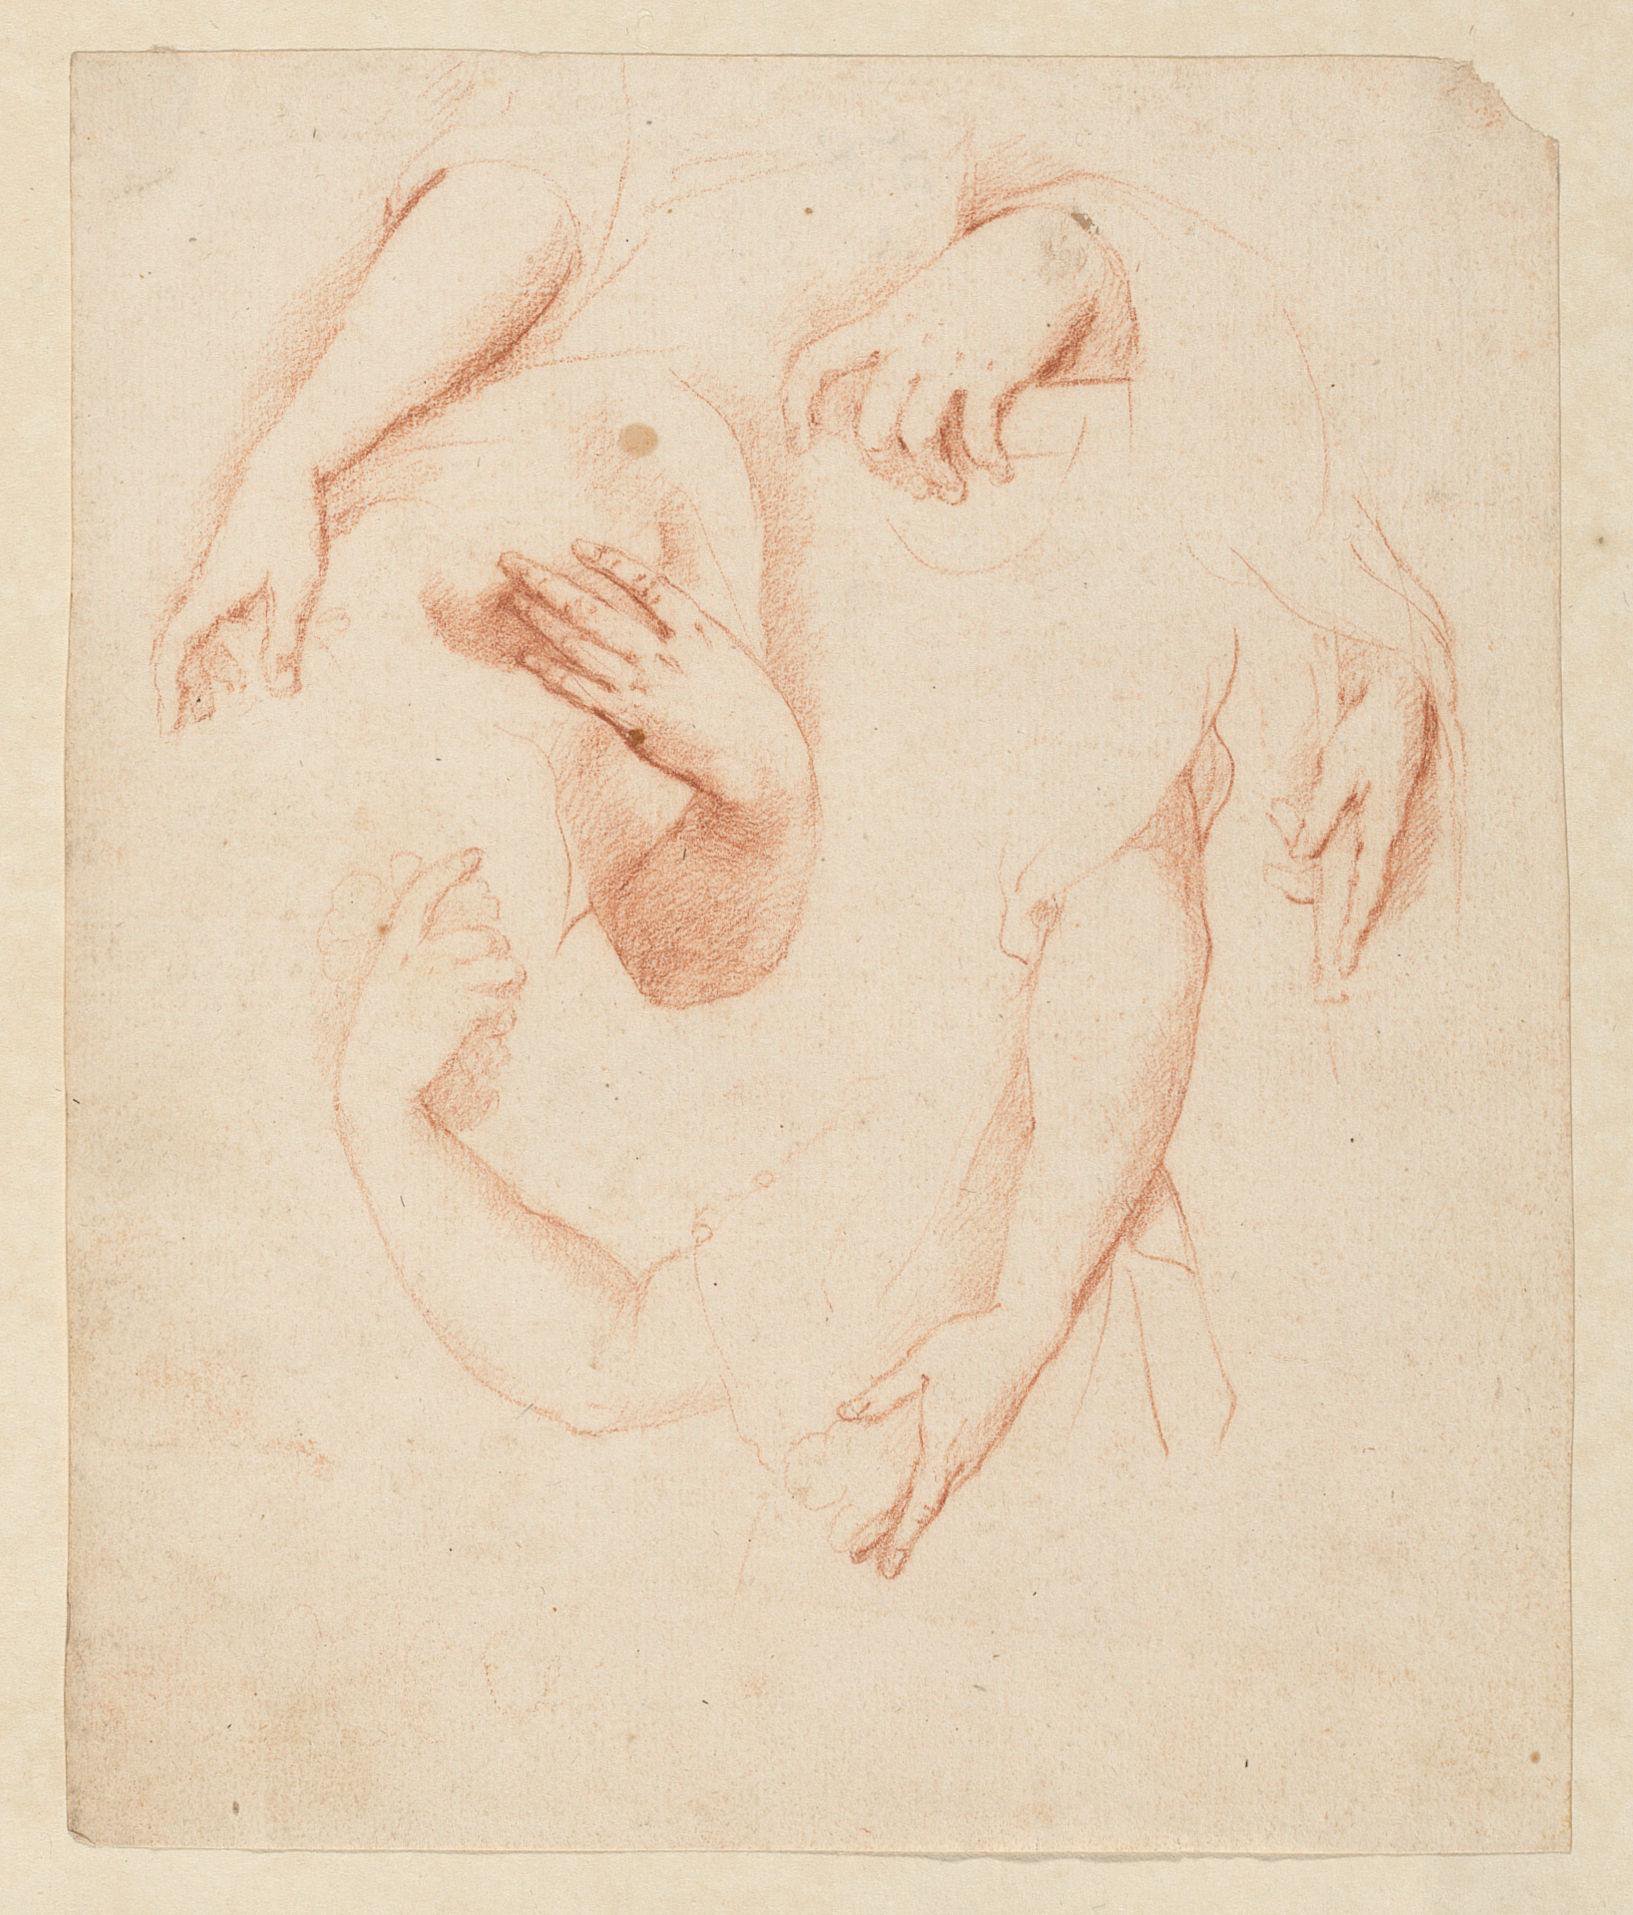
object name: album leaf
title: Studie van armen en handen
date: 1649-1723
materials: chalk, paper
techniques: pasting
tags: postures and gestures of hand and fingers, lower arm